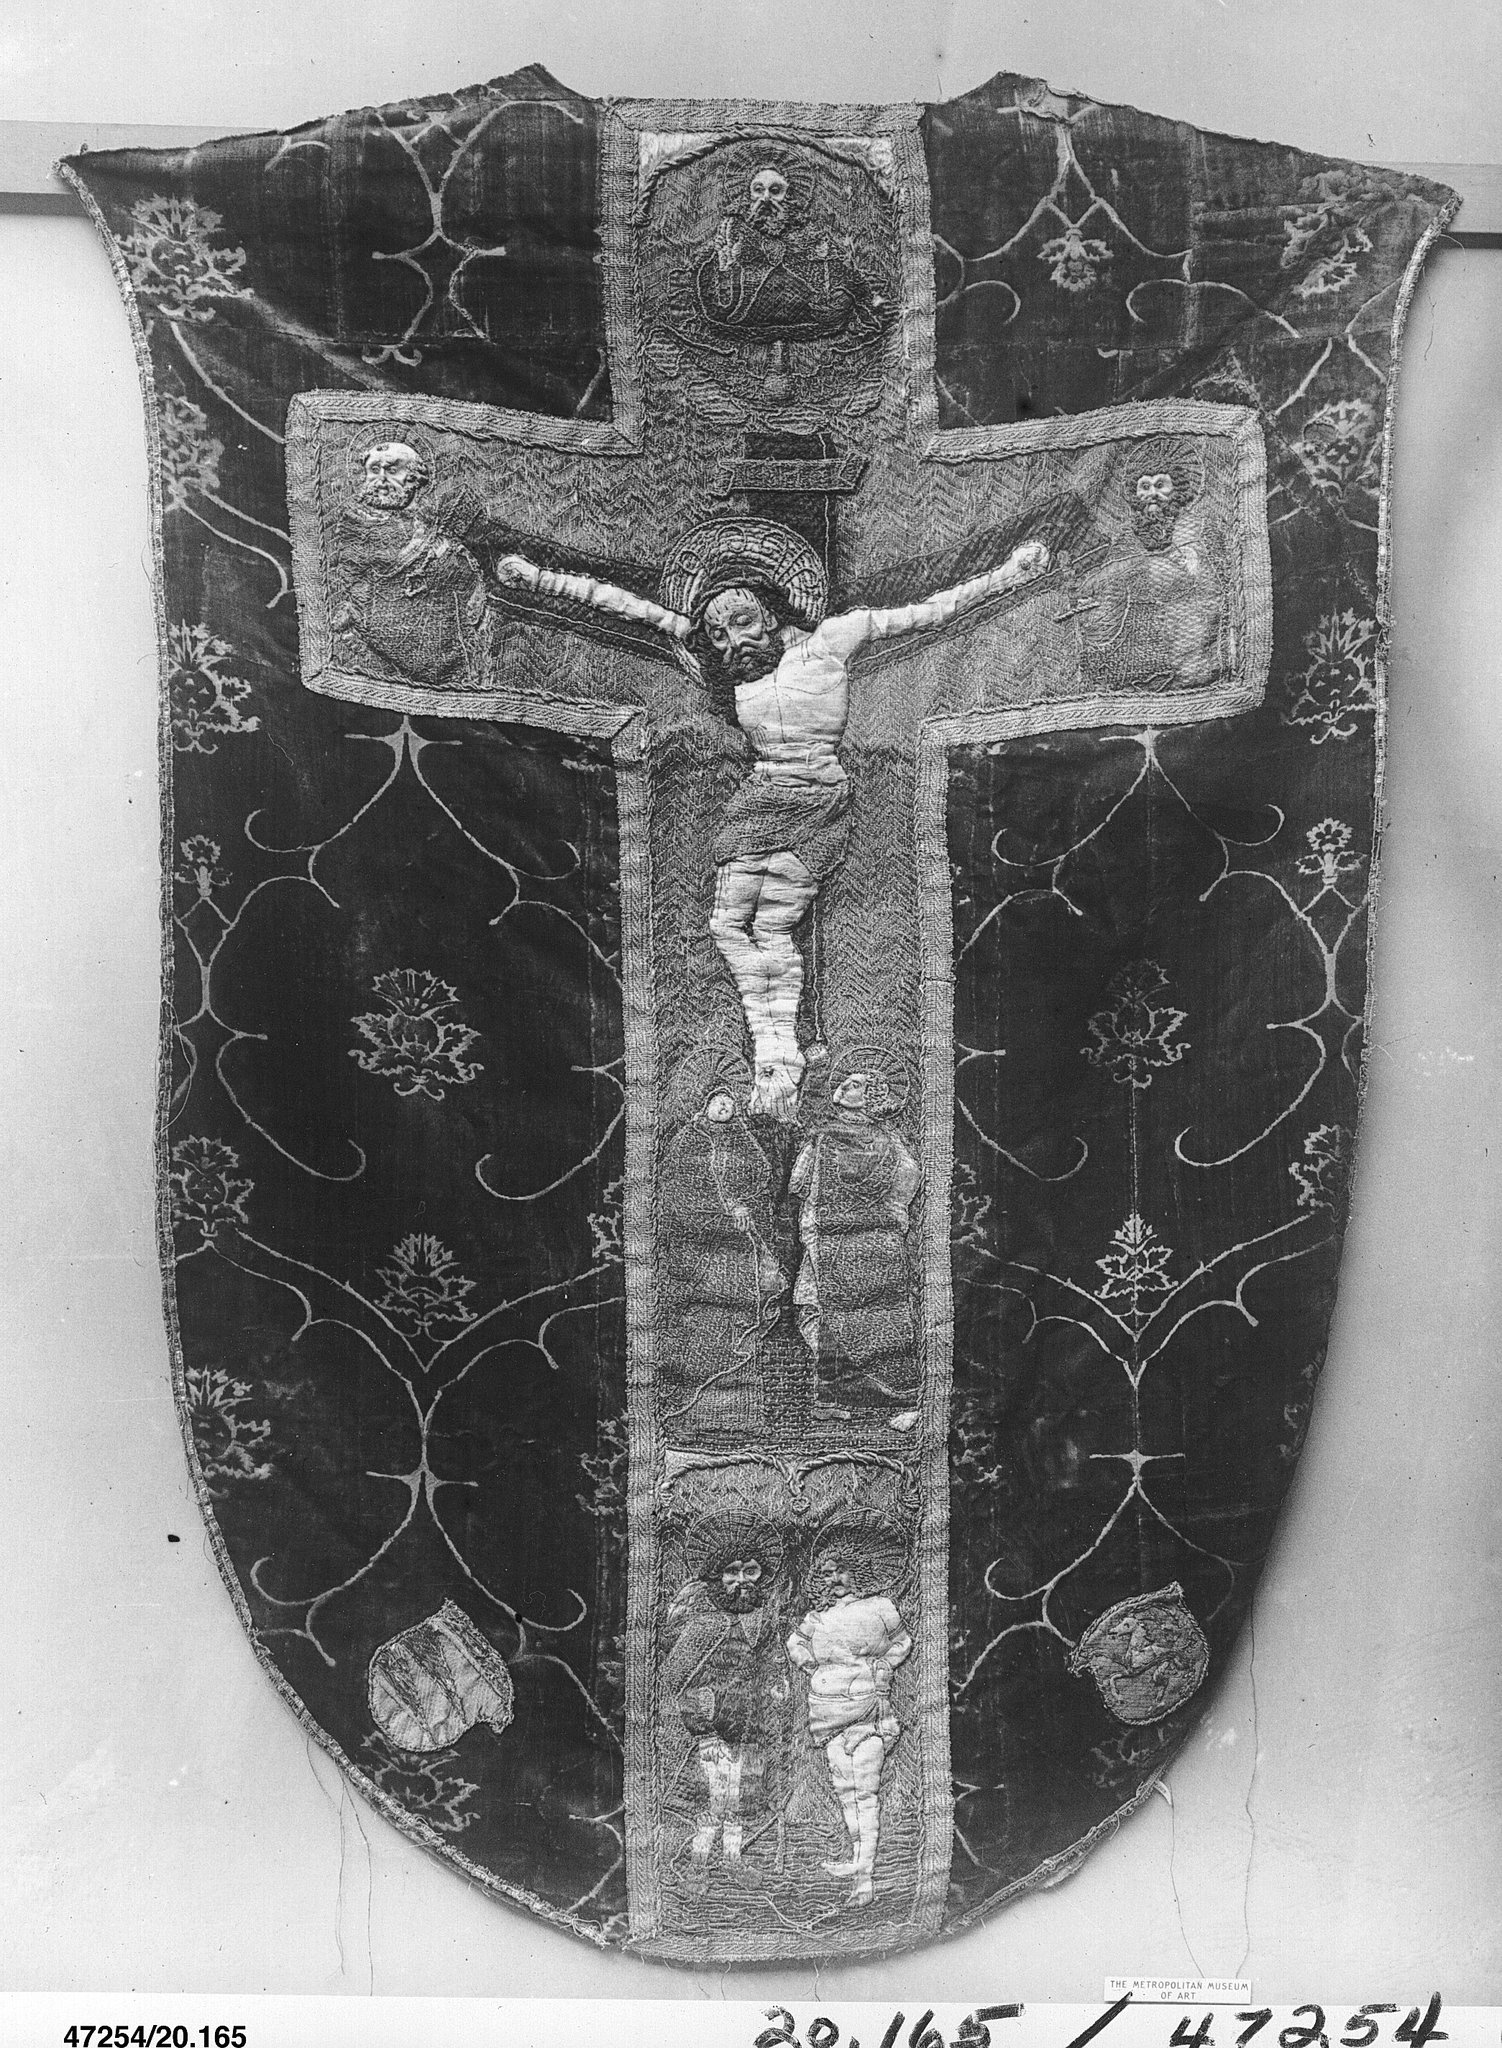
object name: chasuble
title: Chasuble Back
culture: italian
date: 1501-1600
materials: velvet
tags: christ